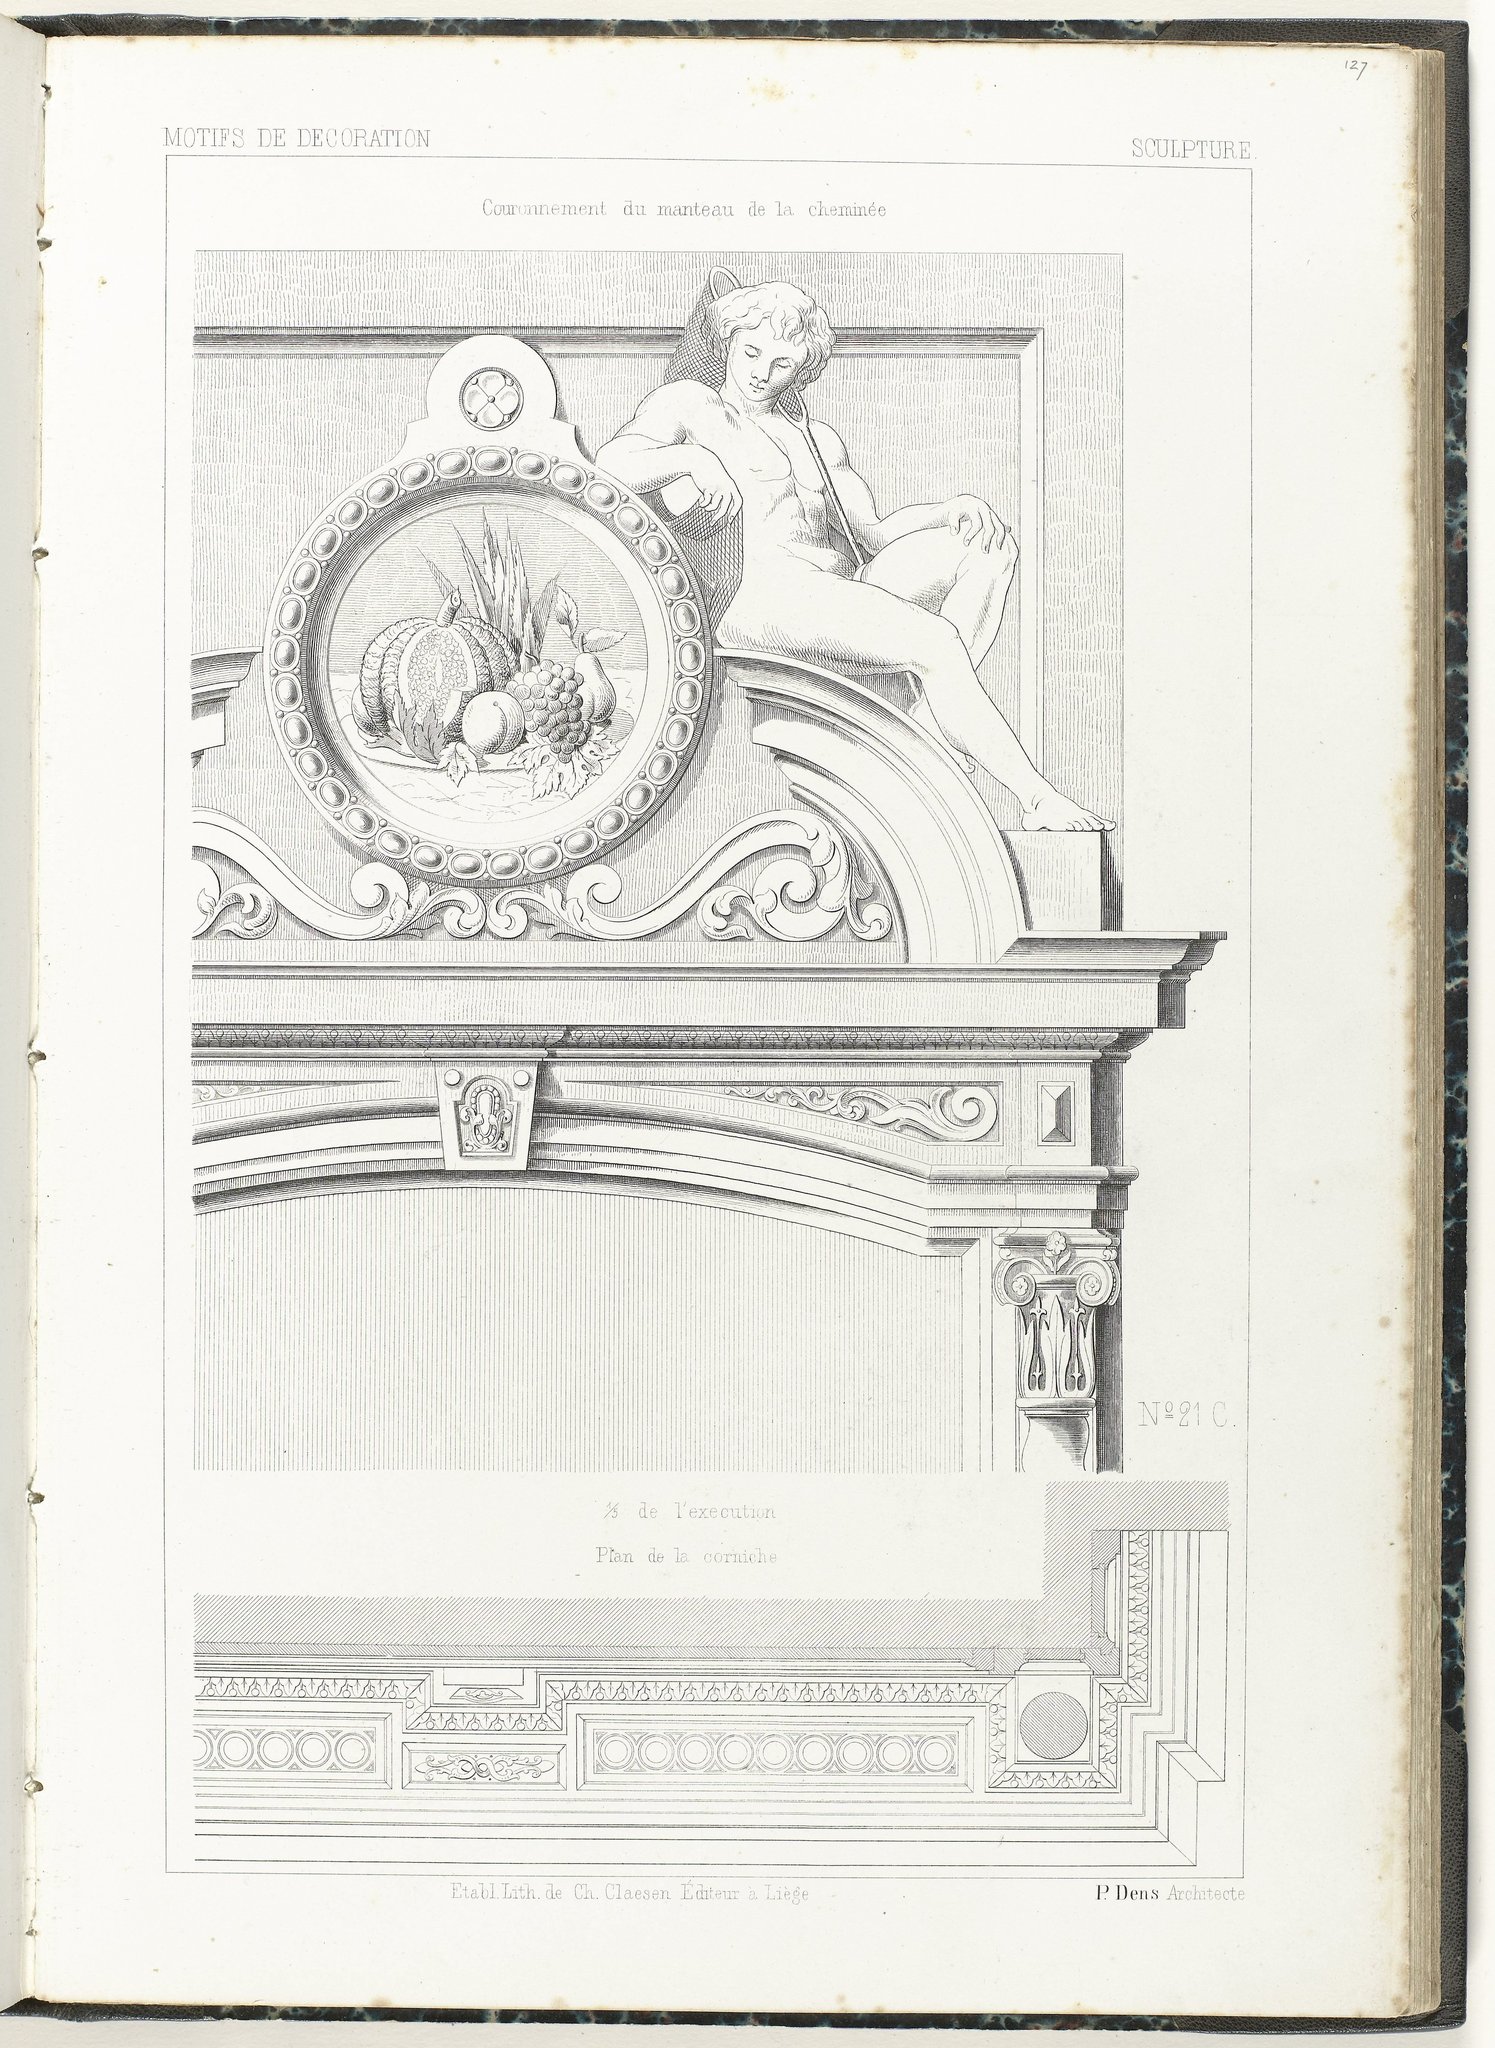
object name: print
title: Kroonlijst van schoorsteenmantel met plan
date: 1866-1900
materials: paper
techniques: lithograph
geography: liège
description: Kroonlijst met bovenaan een stilleven van fruit in een medaillon. Linksboven staat: Motifs de decoration, rechtsboven: Sculpture, rechtsonder: N° 21 C.